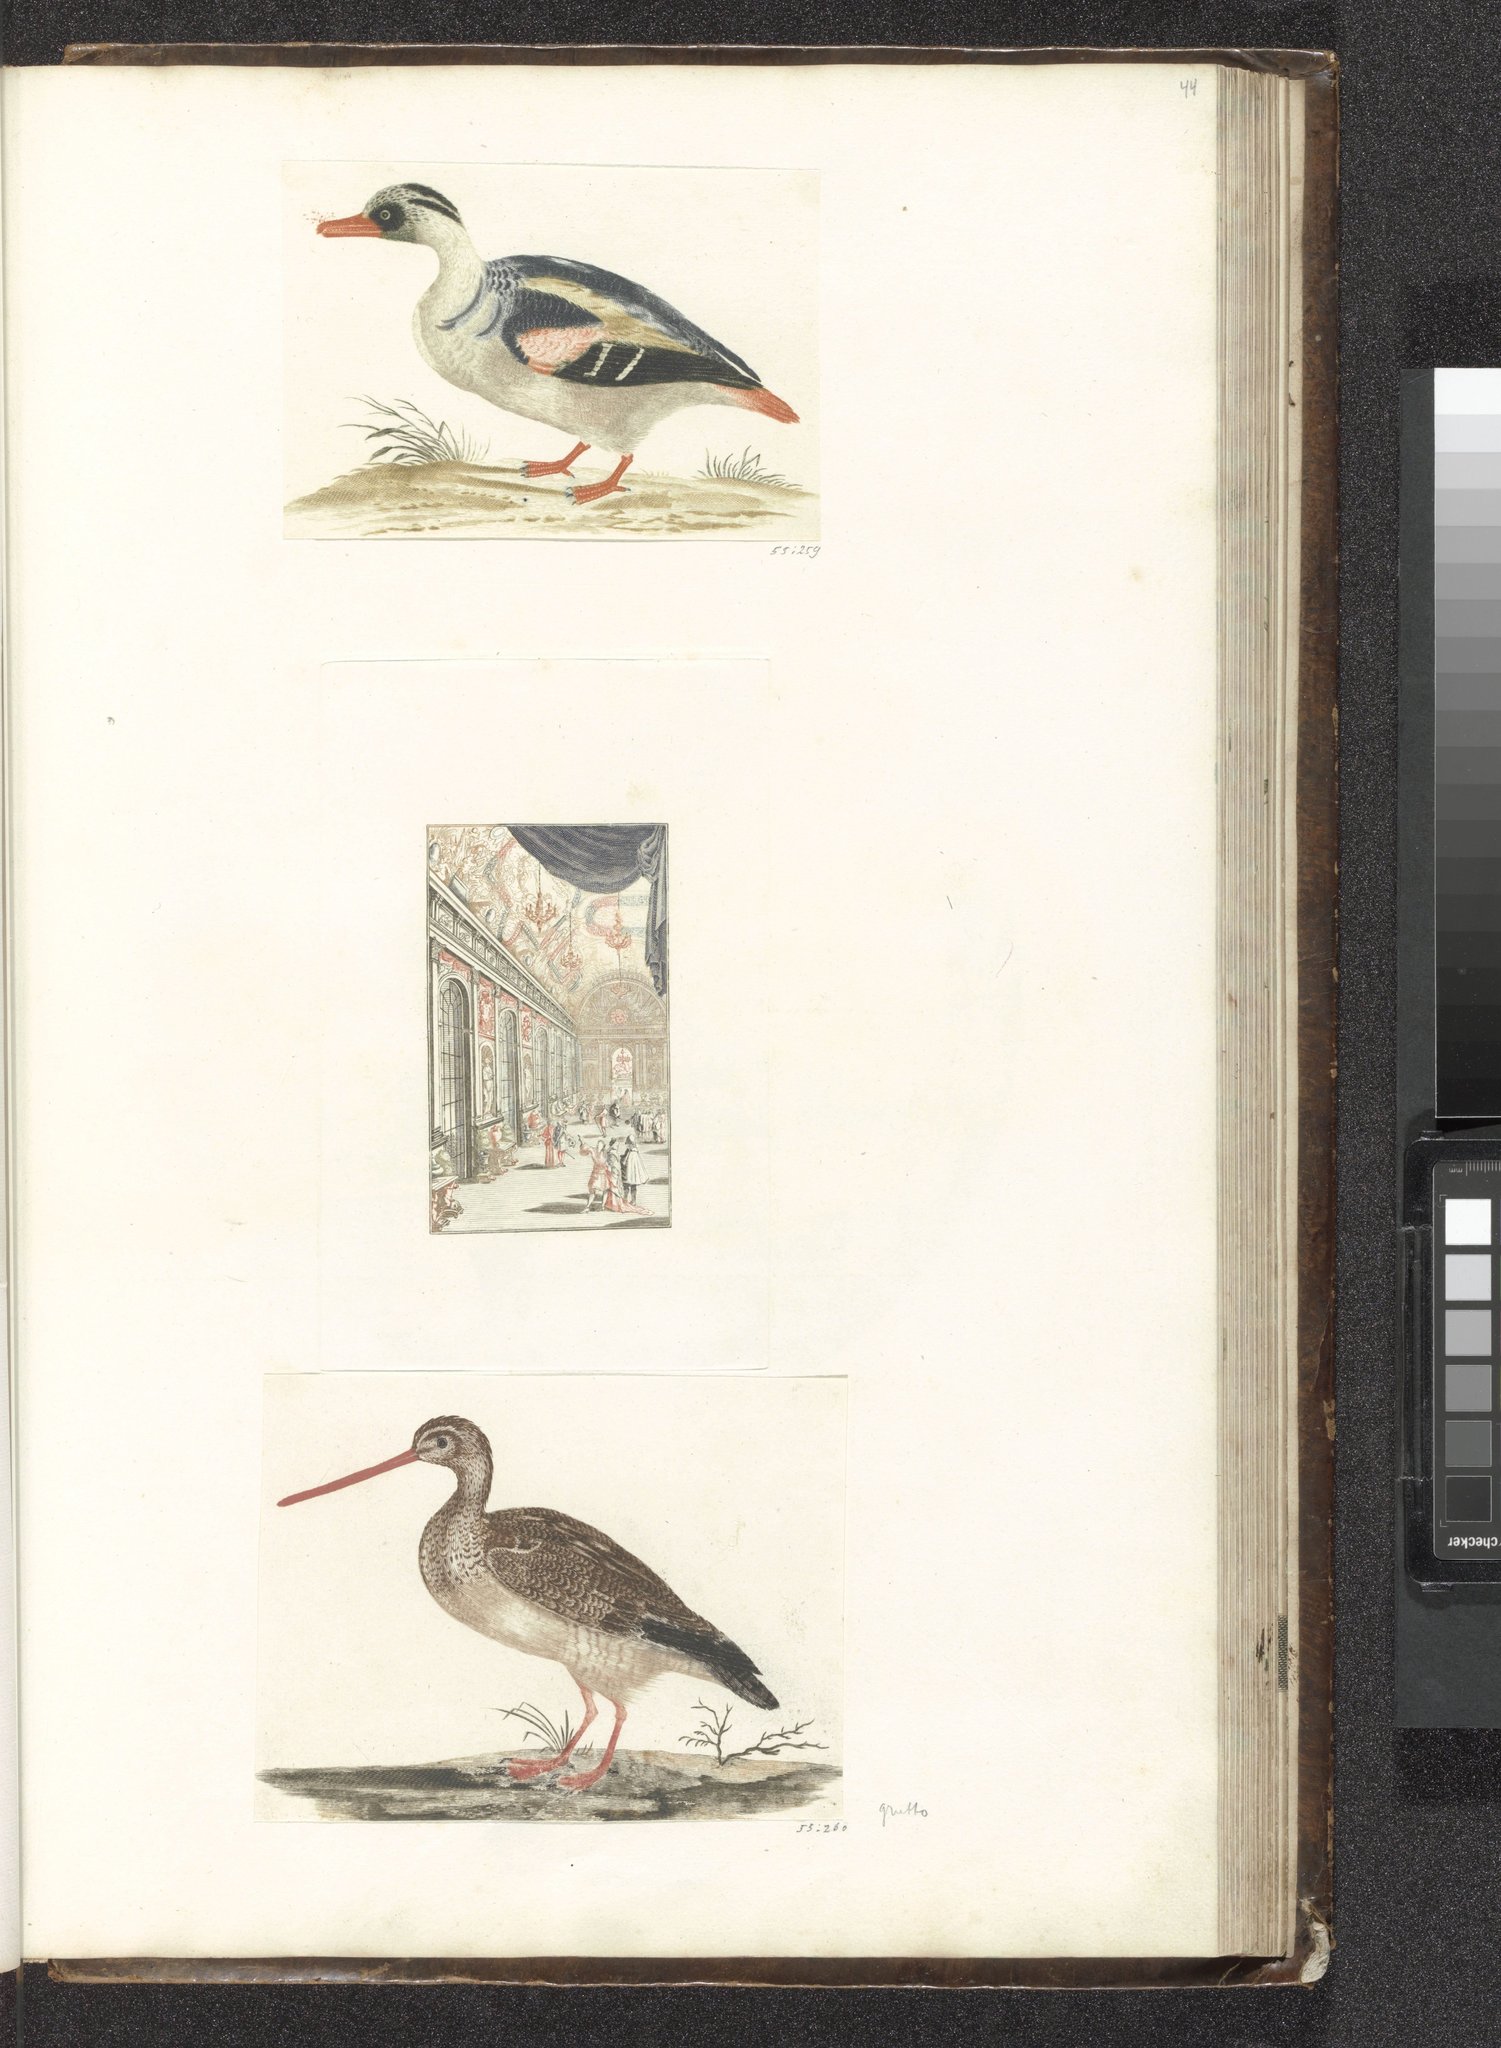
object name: print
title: Grutto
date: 1688-1698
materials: paper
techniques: printing, engraving, lithography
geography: netherlands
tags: birds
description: Deze prent maakt deel uit van een album.